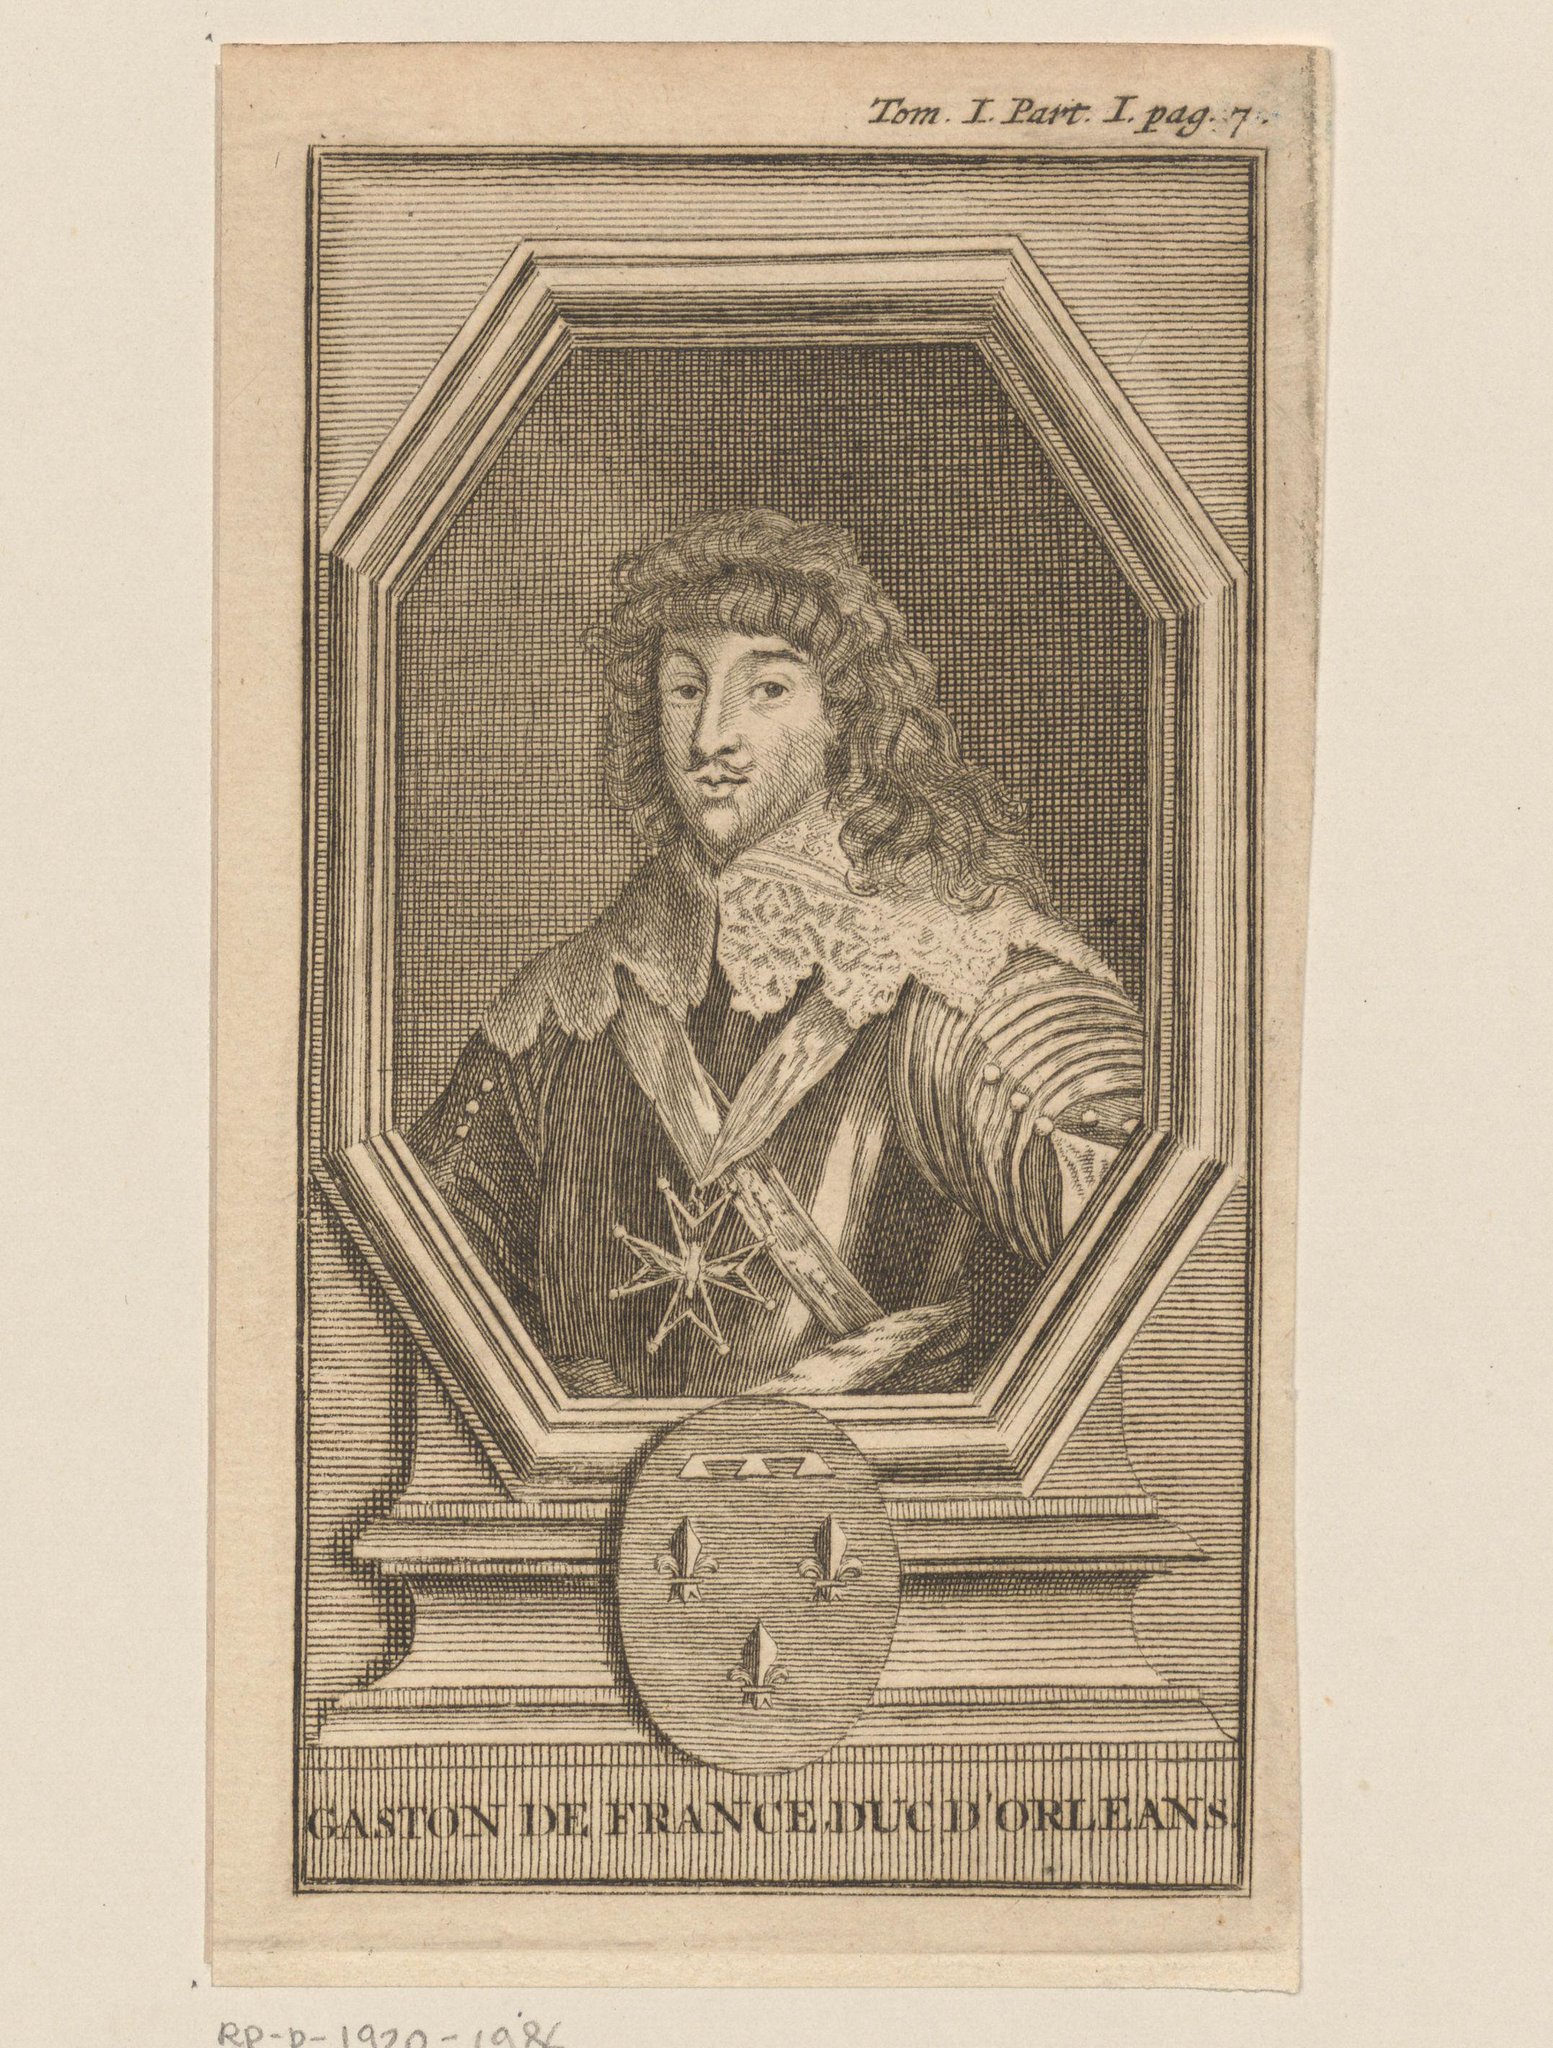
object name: print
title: Portret van Gaston Jean-Baptiste Orléans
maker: Anonymous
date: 1654-1660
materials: paper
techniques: engraving, etching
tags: gaston jean-baptiste hertog van orléans, historical persons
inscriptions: collector's mark: Lugt 2228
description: Prent mogelijk uit: Vassor, Michel le. Histoire du regne de Louis XIII. Amsterdam: Pierre Brunel, 1707.